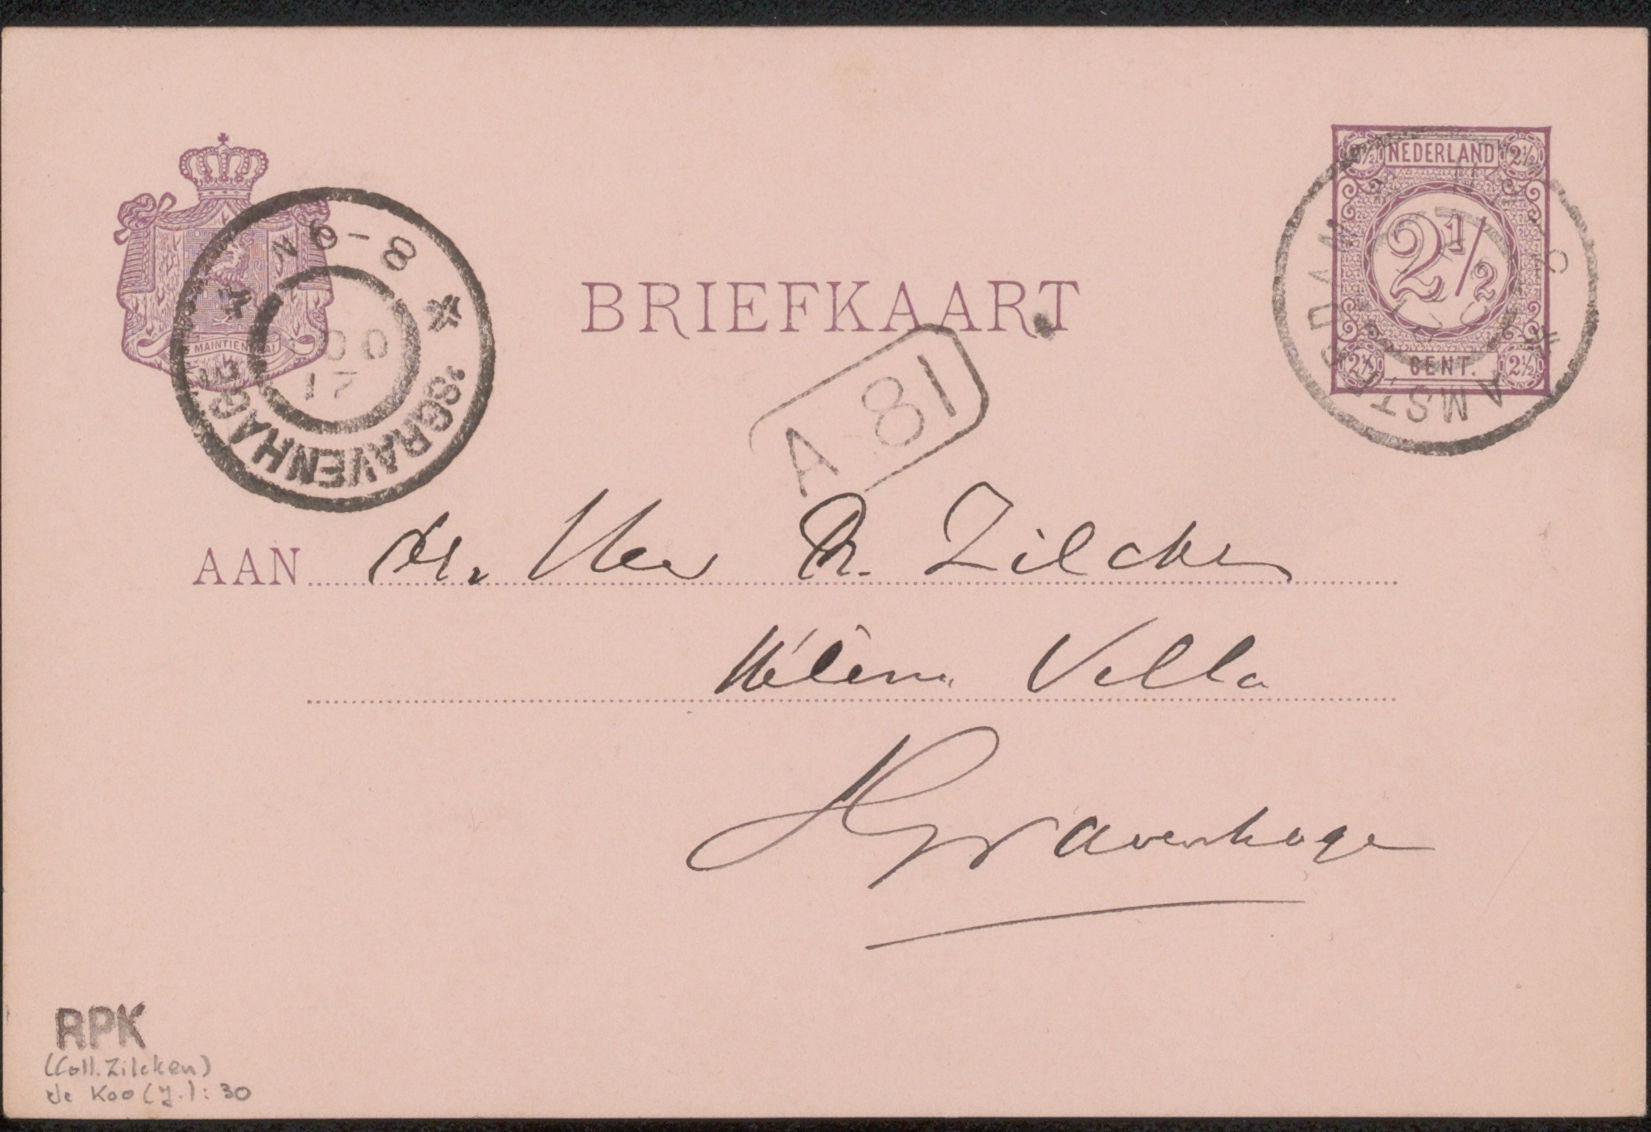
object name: postcard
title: Briefkaart aan Philip Zilcken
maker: johannes de koo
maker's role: auteur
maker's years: 1841-1909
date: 1851-1909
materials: cardboard, ink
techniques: pen, writing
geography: hilversum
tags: the hague, painter, draughtsman, philip zilcken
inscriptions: collector's mark: ‘RPK’